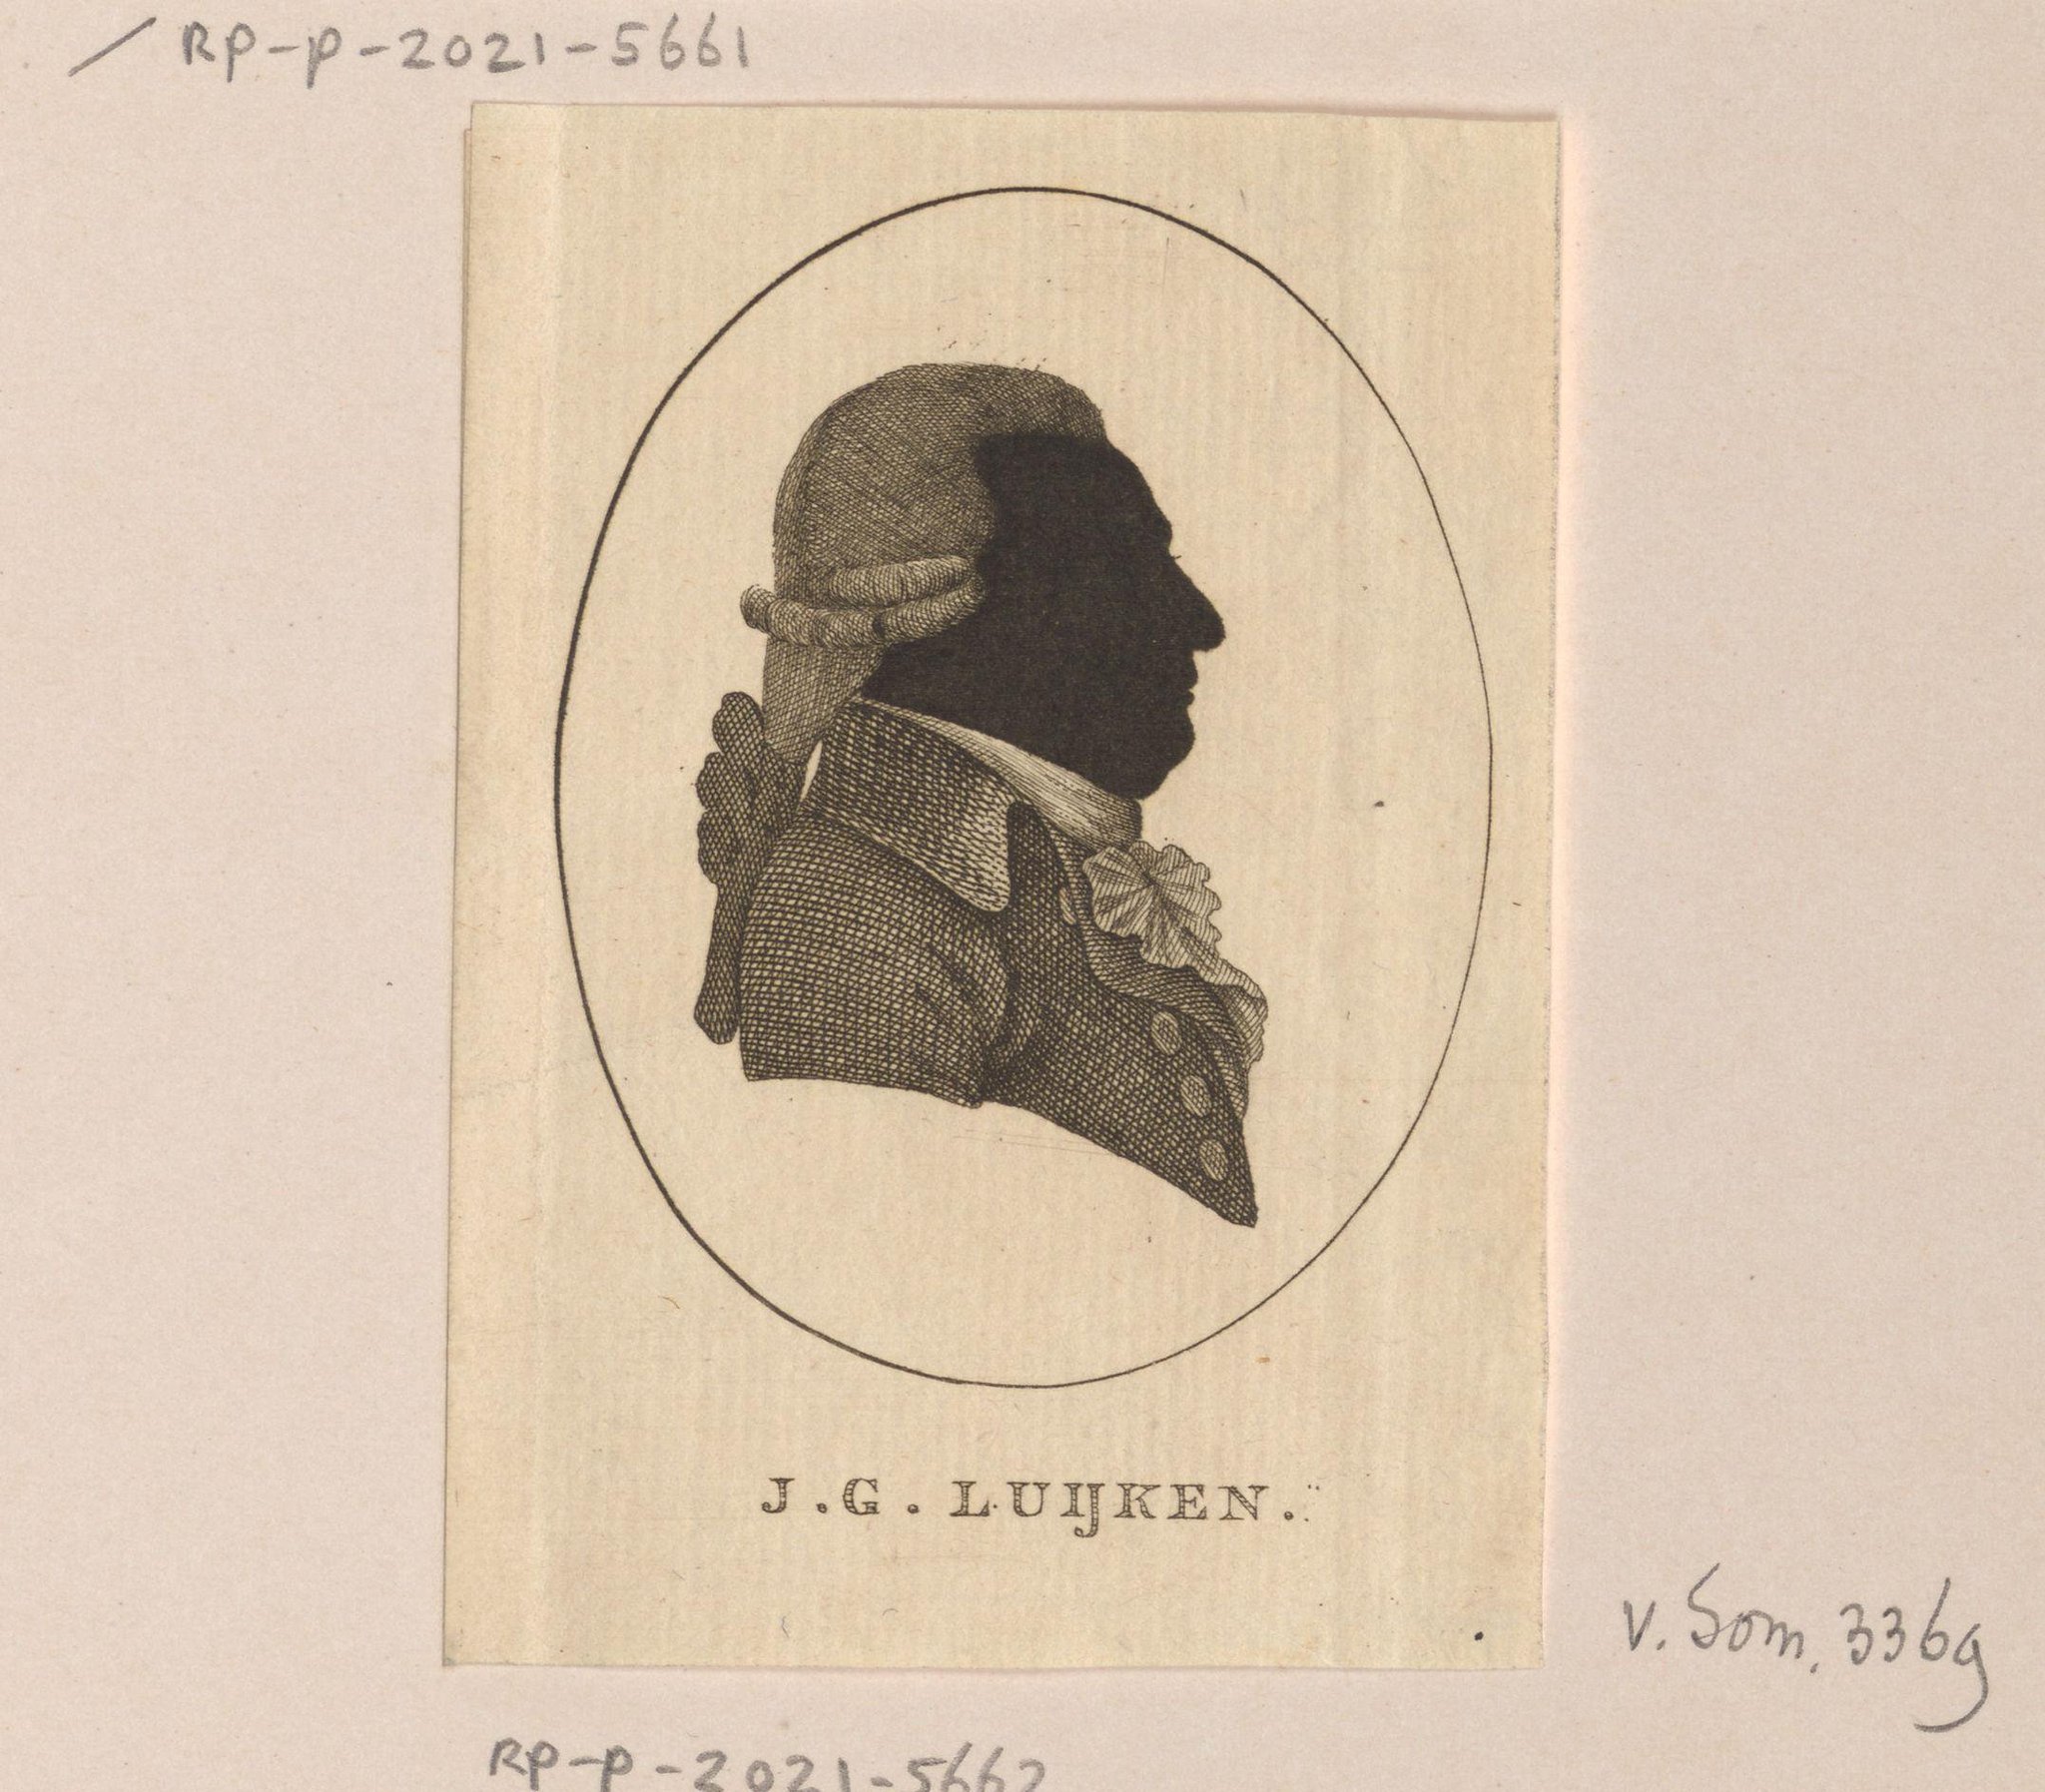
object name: book illustration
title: Silhouetportret van Johannes Gerardus Luyken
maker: Anonymous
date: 1799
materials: paper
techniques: etching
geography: netherlands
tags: official; civil servant; functionary (in general), historical persons, wig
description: Prent waarschijnlijk uit: Rogge, Cornelius. Geschiedenis der staatsregeling, voor het Bataafsche volk. Amsterdam: Johannes Allart, 1799.